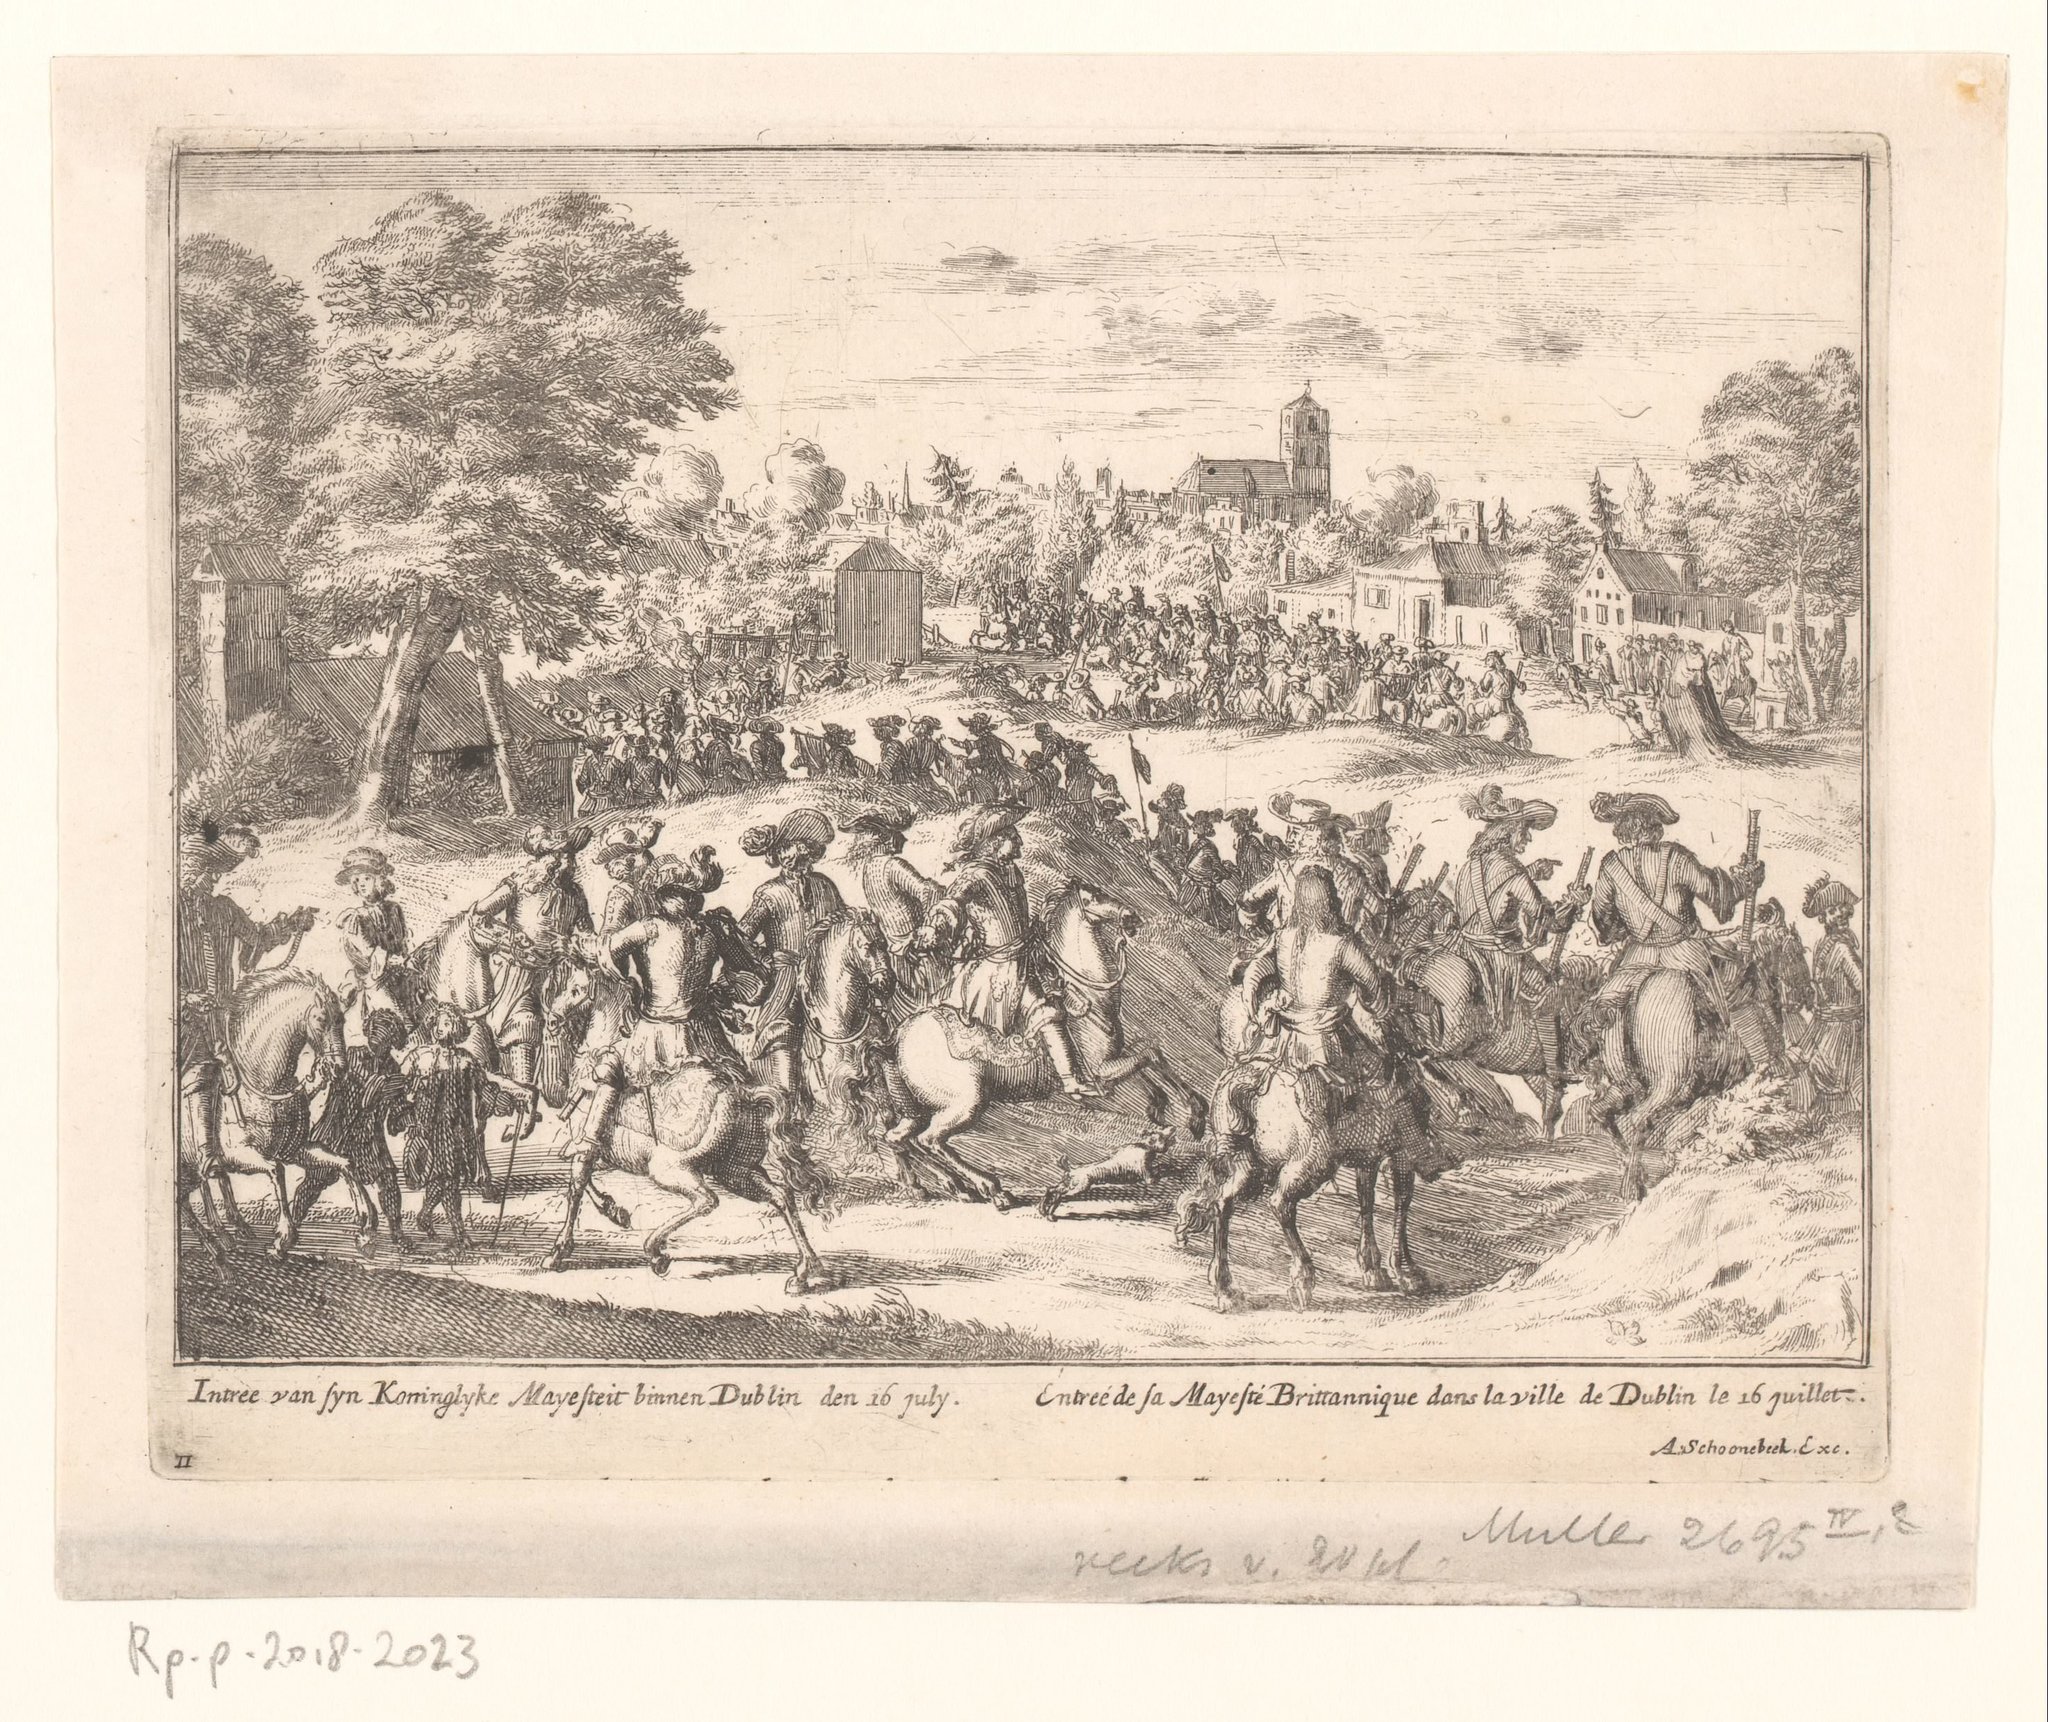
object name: print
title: Intree van syn Koninglyke Mayesteit binnen Dublin den 16 july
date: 1691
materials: paper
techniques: etching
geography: amsterdam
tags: the hague, william iii (prince of orange and king of england, scotland, and ireland)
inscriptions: collector's mark: Lugt 2228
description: Koning Willem III trekt met zijn legers Dublin in, 16 juli 1690. Plaat nr. 11 in de serie 'Engelants schouwtoneel' over de oorlog tussen Willem III en Jacobus II in de jaren 1690-1691 na de Glorious Revolution, (derde deel). Met onderschriften in het Nederlands en Frans.